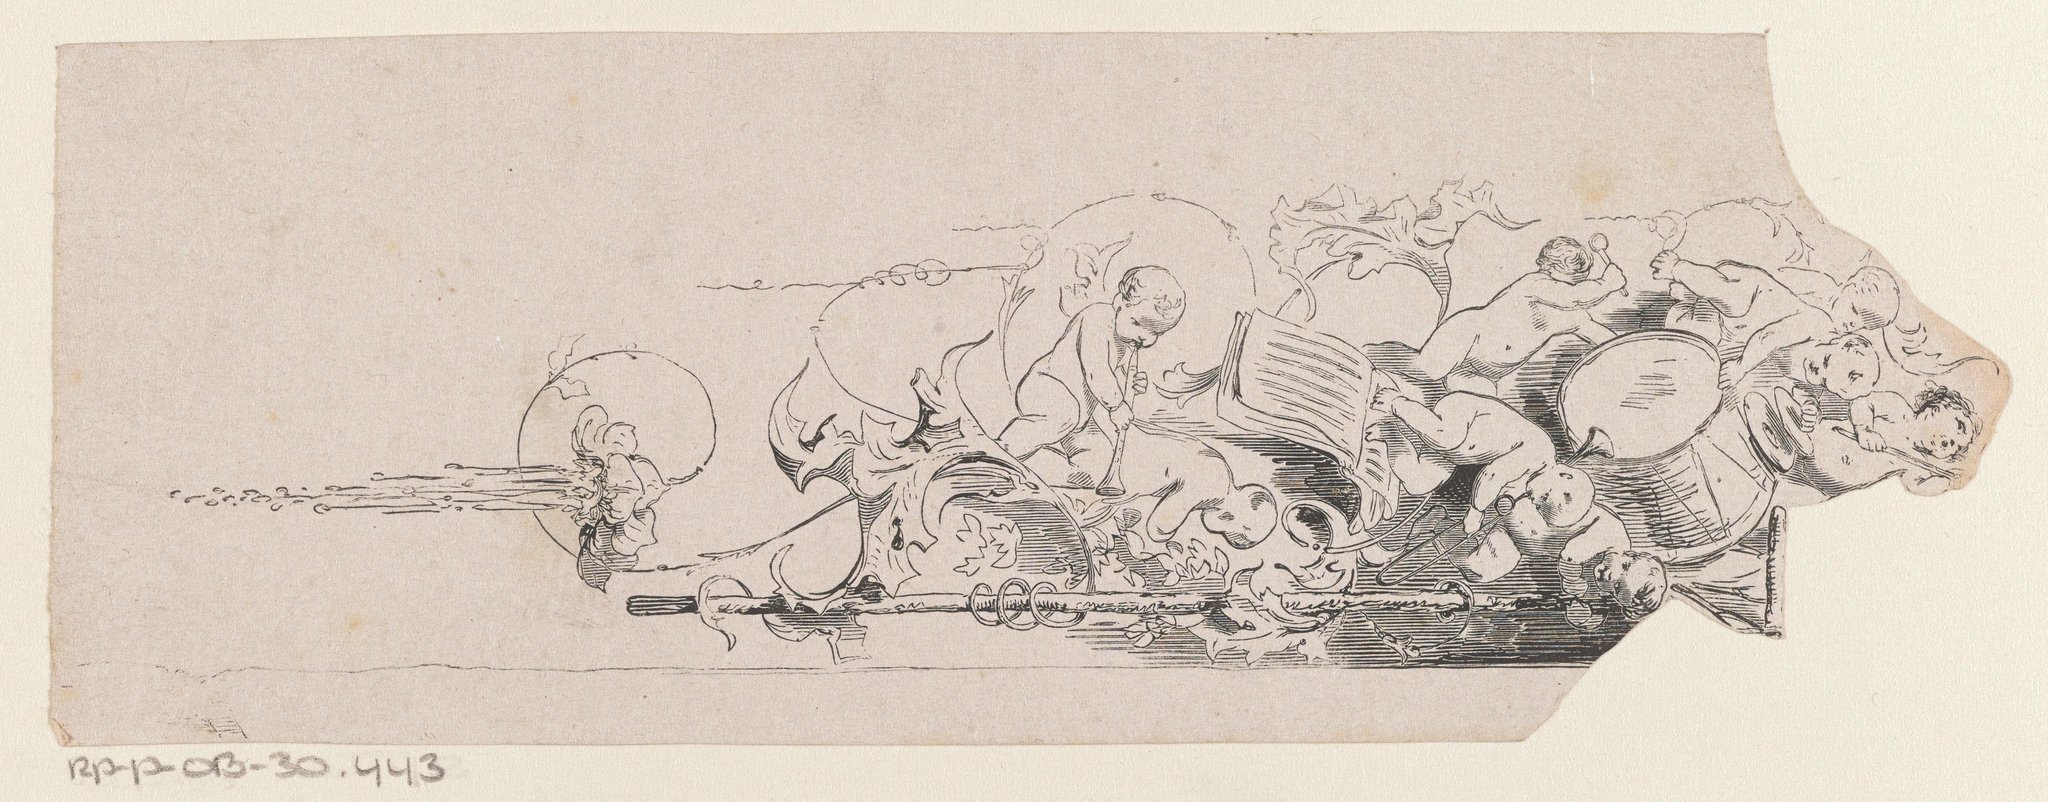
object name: print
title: Musicerende putti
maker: isaac weissenbruch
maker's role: print maker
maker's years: 1826-1912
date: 1836-1912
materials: paper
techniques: engraving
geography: netherlands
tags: drum (musical instrument), wind instruments, cupids: 'amores', 'amoretti', 'putti', more than one musician with instrument